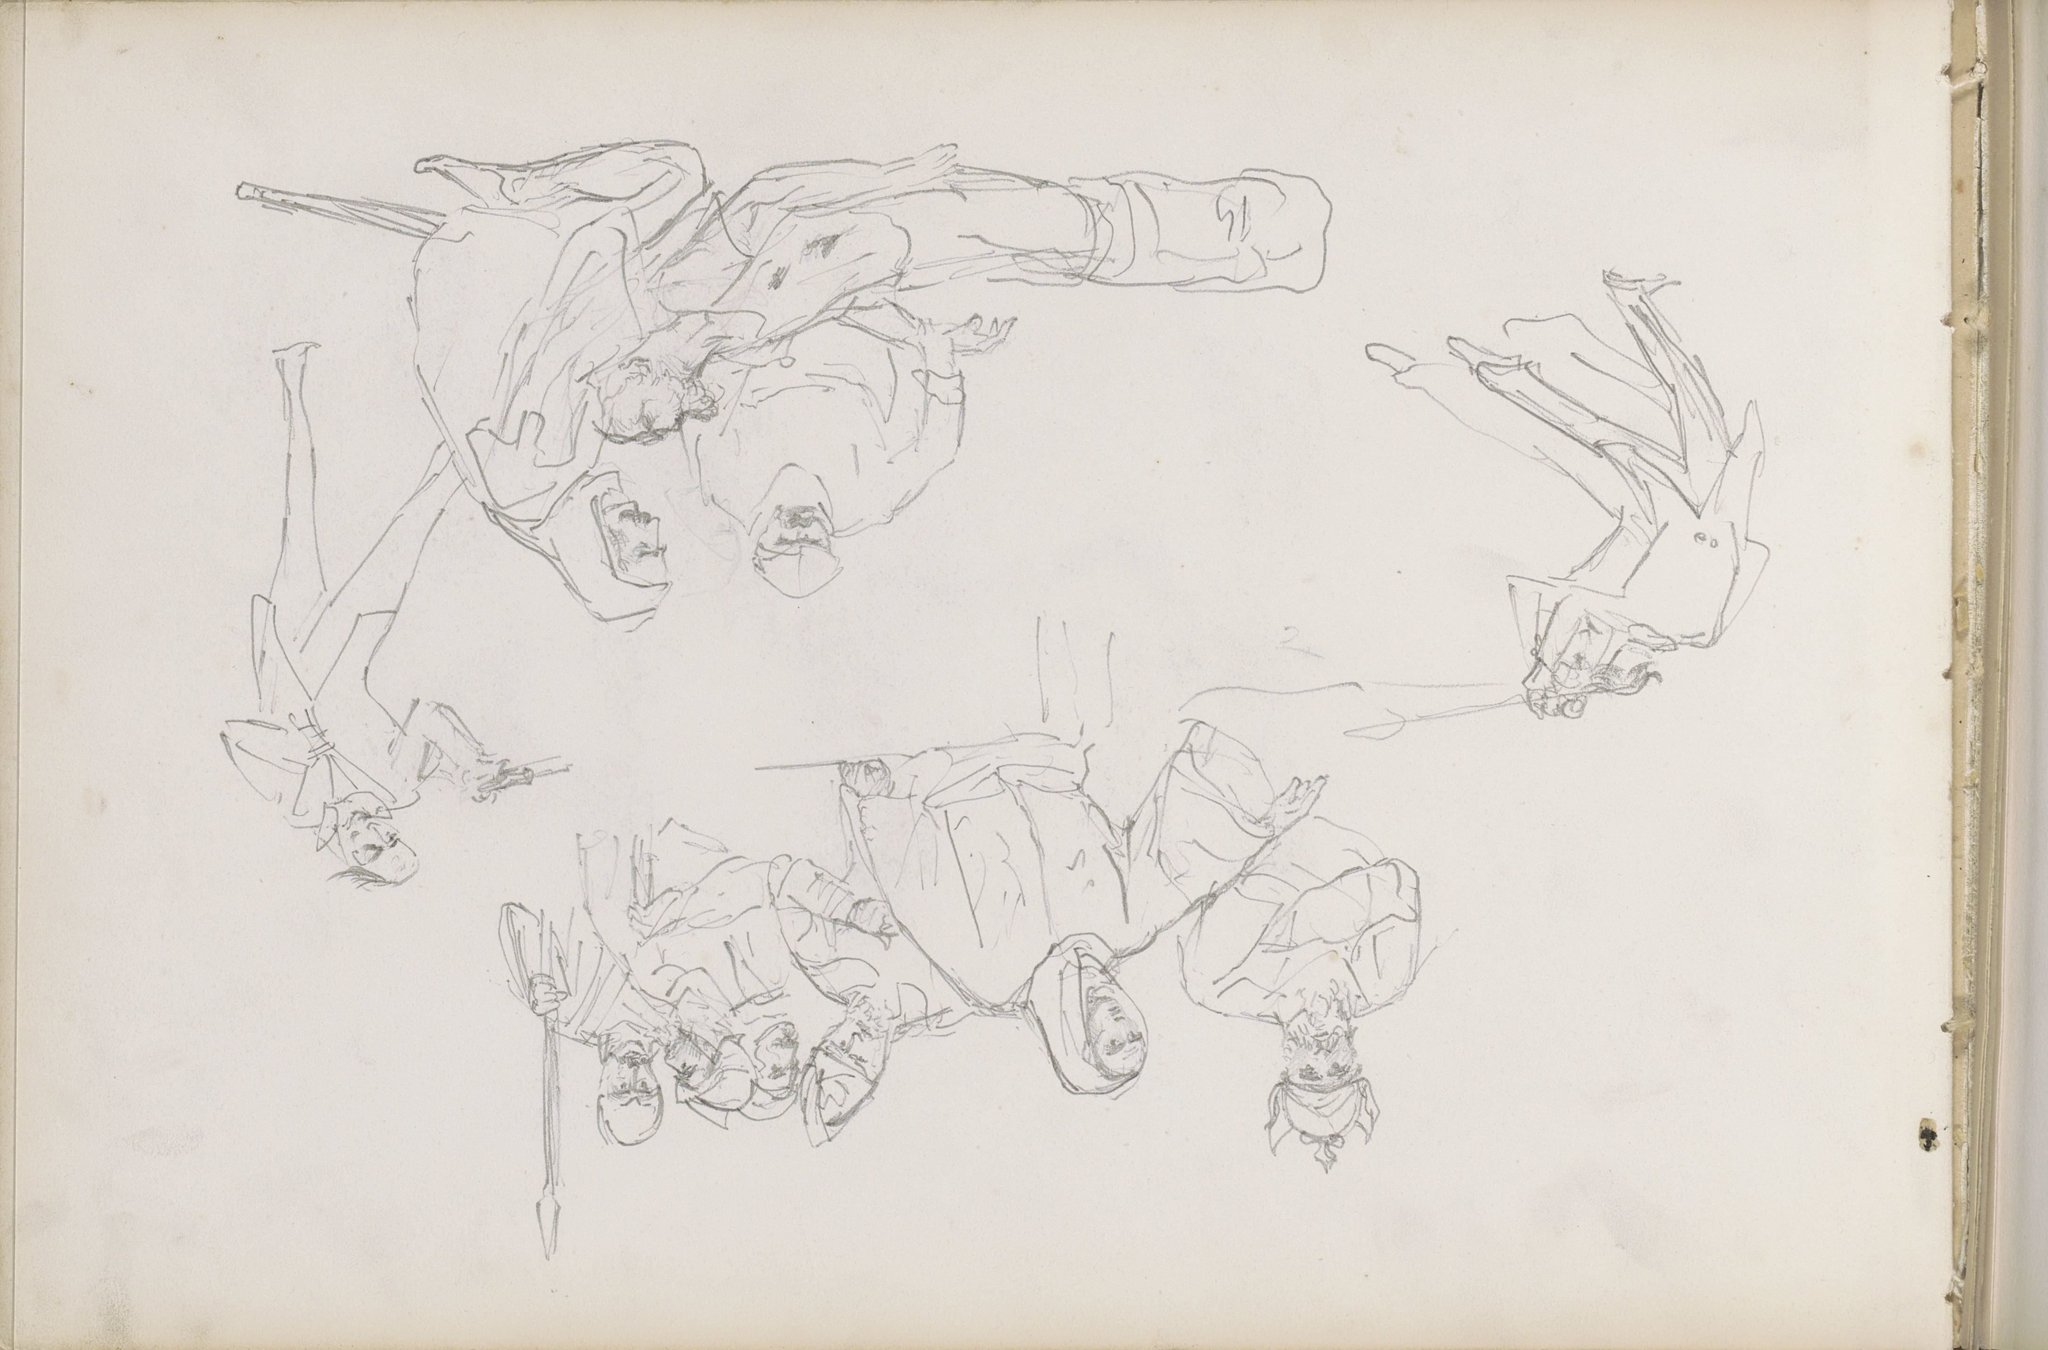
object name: sketchbook leaf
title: Figuurstudies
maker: george hendrik breitner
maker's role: draughtsman, painter, print maker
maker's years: 1857-1923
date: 1873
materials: paper, pencil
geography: rotterdam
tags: division of armed forces (+ land forces), transport of the sick, wounded and dead (military), knight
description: Gewapende figuren en mannen met kappen. Onder wordt een gewonde of dode man door twee mannen ondersteund. Mogelijk scènes uit Ivanhoe. Blad 45 verso uit een schetsboek met 25 bladen.